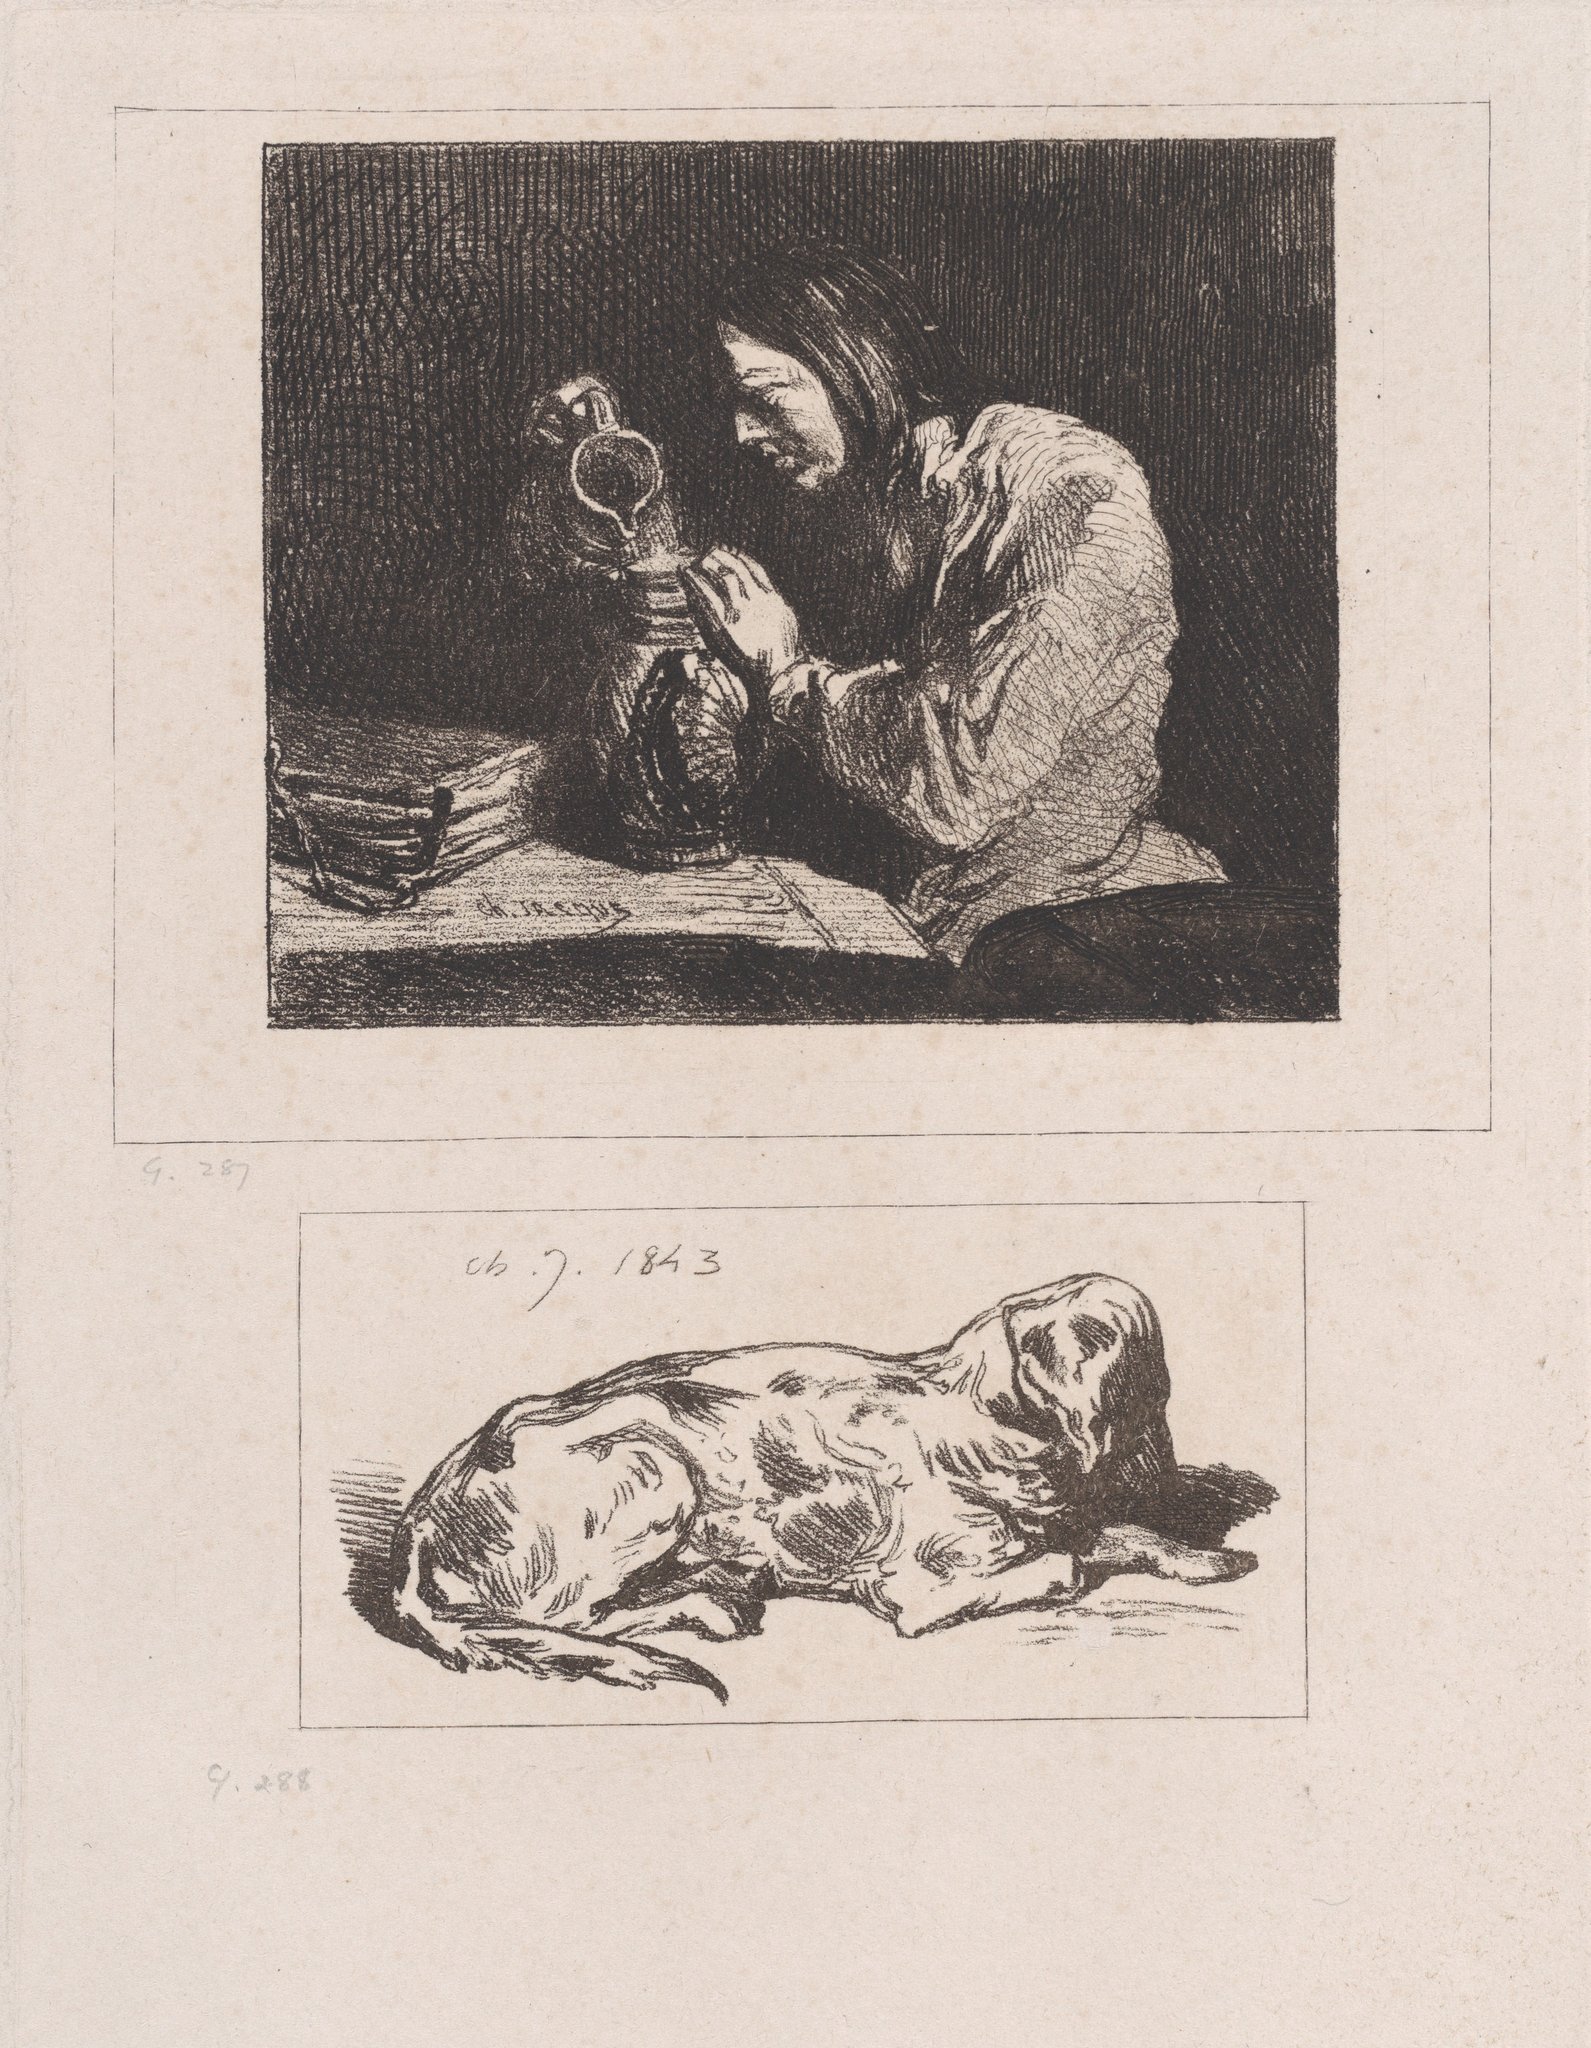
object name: print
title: Bust of a Man (a) and Sleeping Dog (b)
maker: charles émile jacque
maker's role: artist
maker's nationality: french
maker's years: 1813-1894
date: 1843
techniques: etching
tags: men,dogs